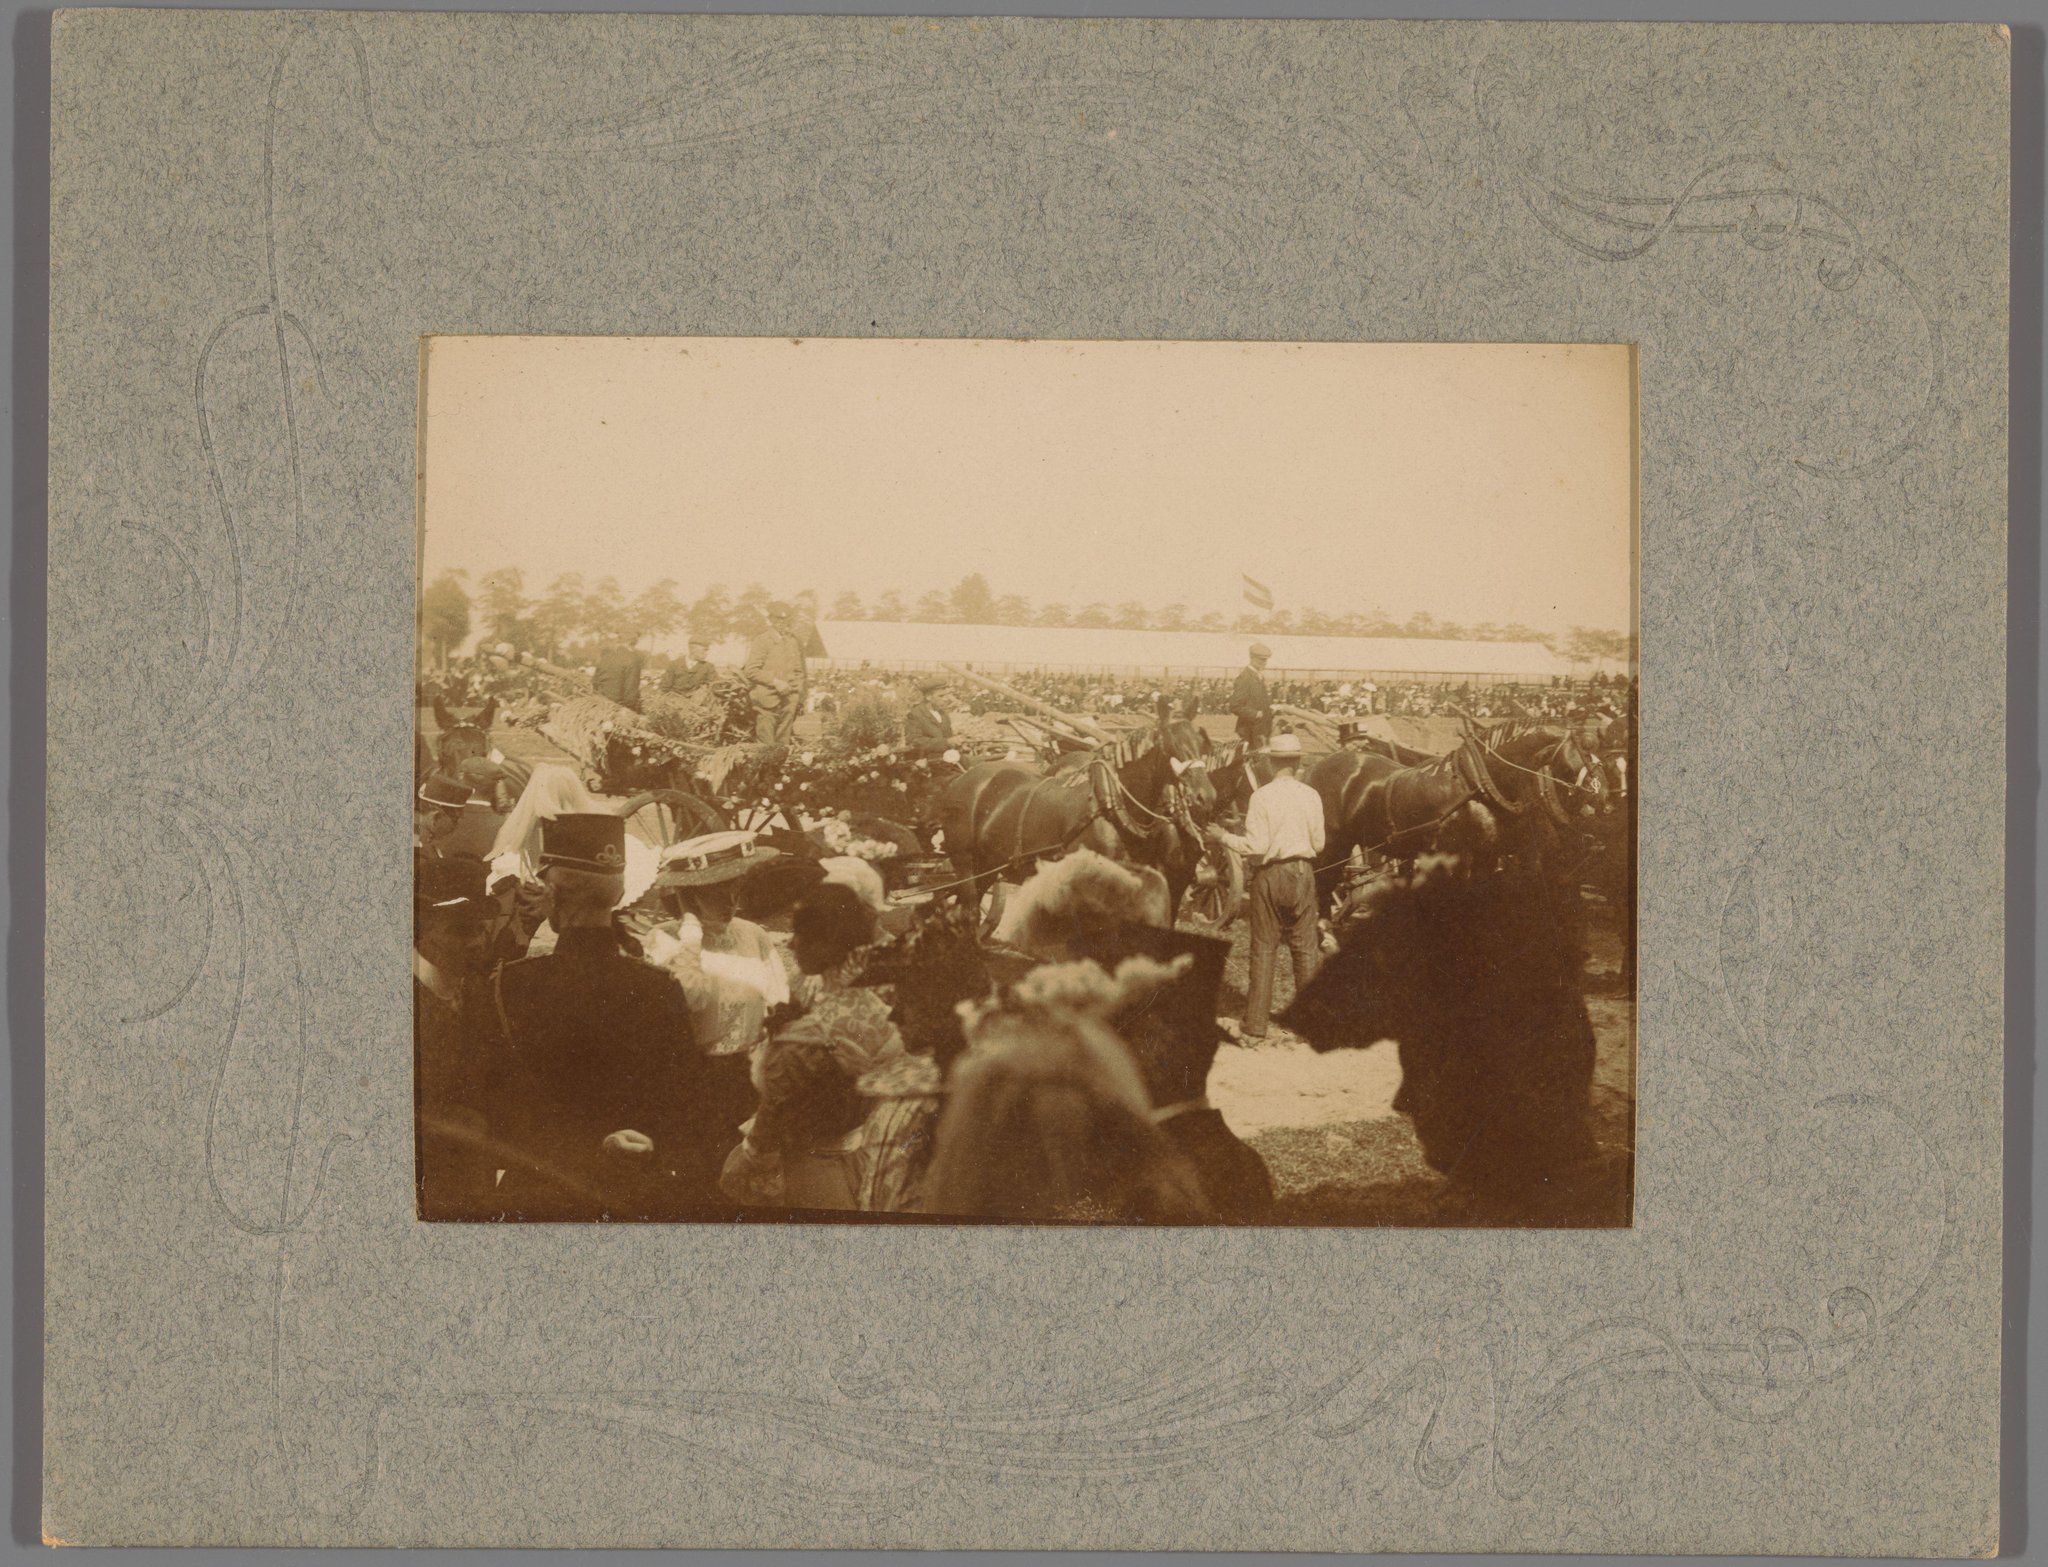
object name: photograph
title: Show met paarden, vermoedelijk in Nederland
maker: Anonymous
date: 1895-1905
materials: paper, cardboard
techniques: gelatin silver print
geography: netherlands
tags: horse